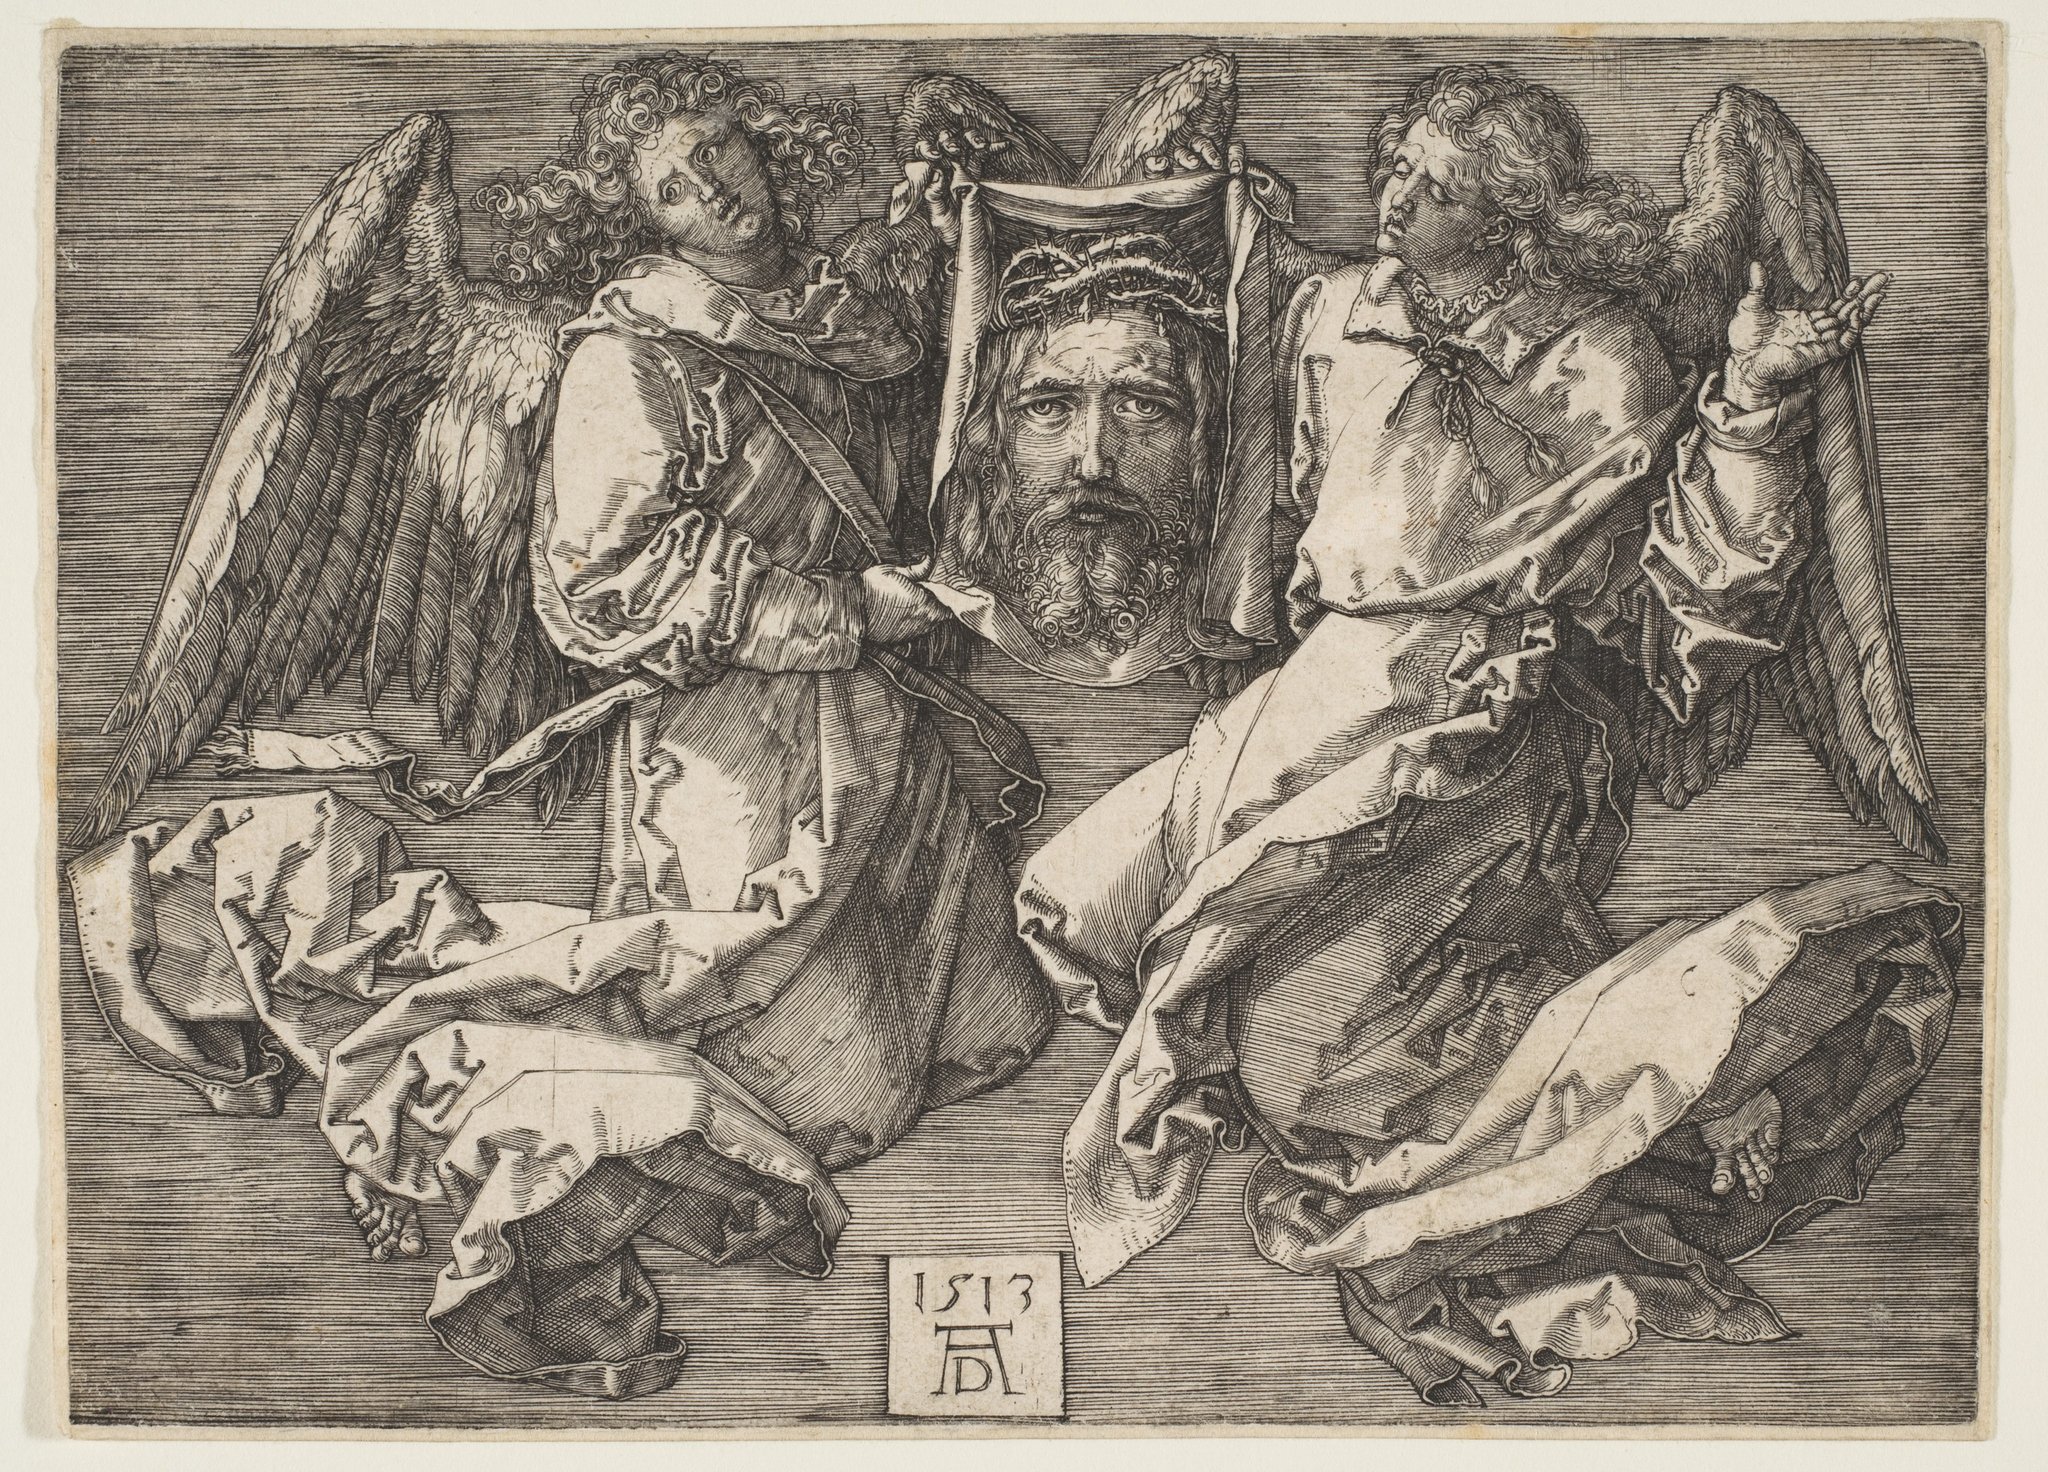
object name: print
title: Sudarium Held by Two Angels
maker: albrecht dürer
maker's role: artist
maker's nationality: german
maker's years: 1471-1528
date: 1513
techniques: engraving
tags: angels,christ